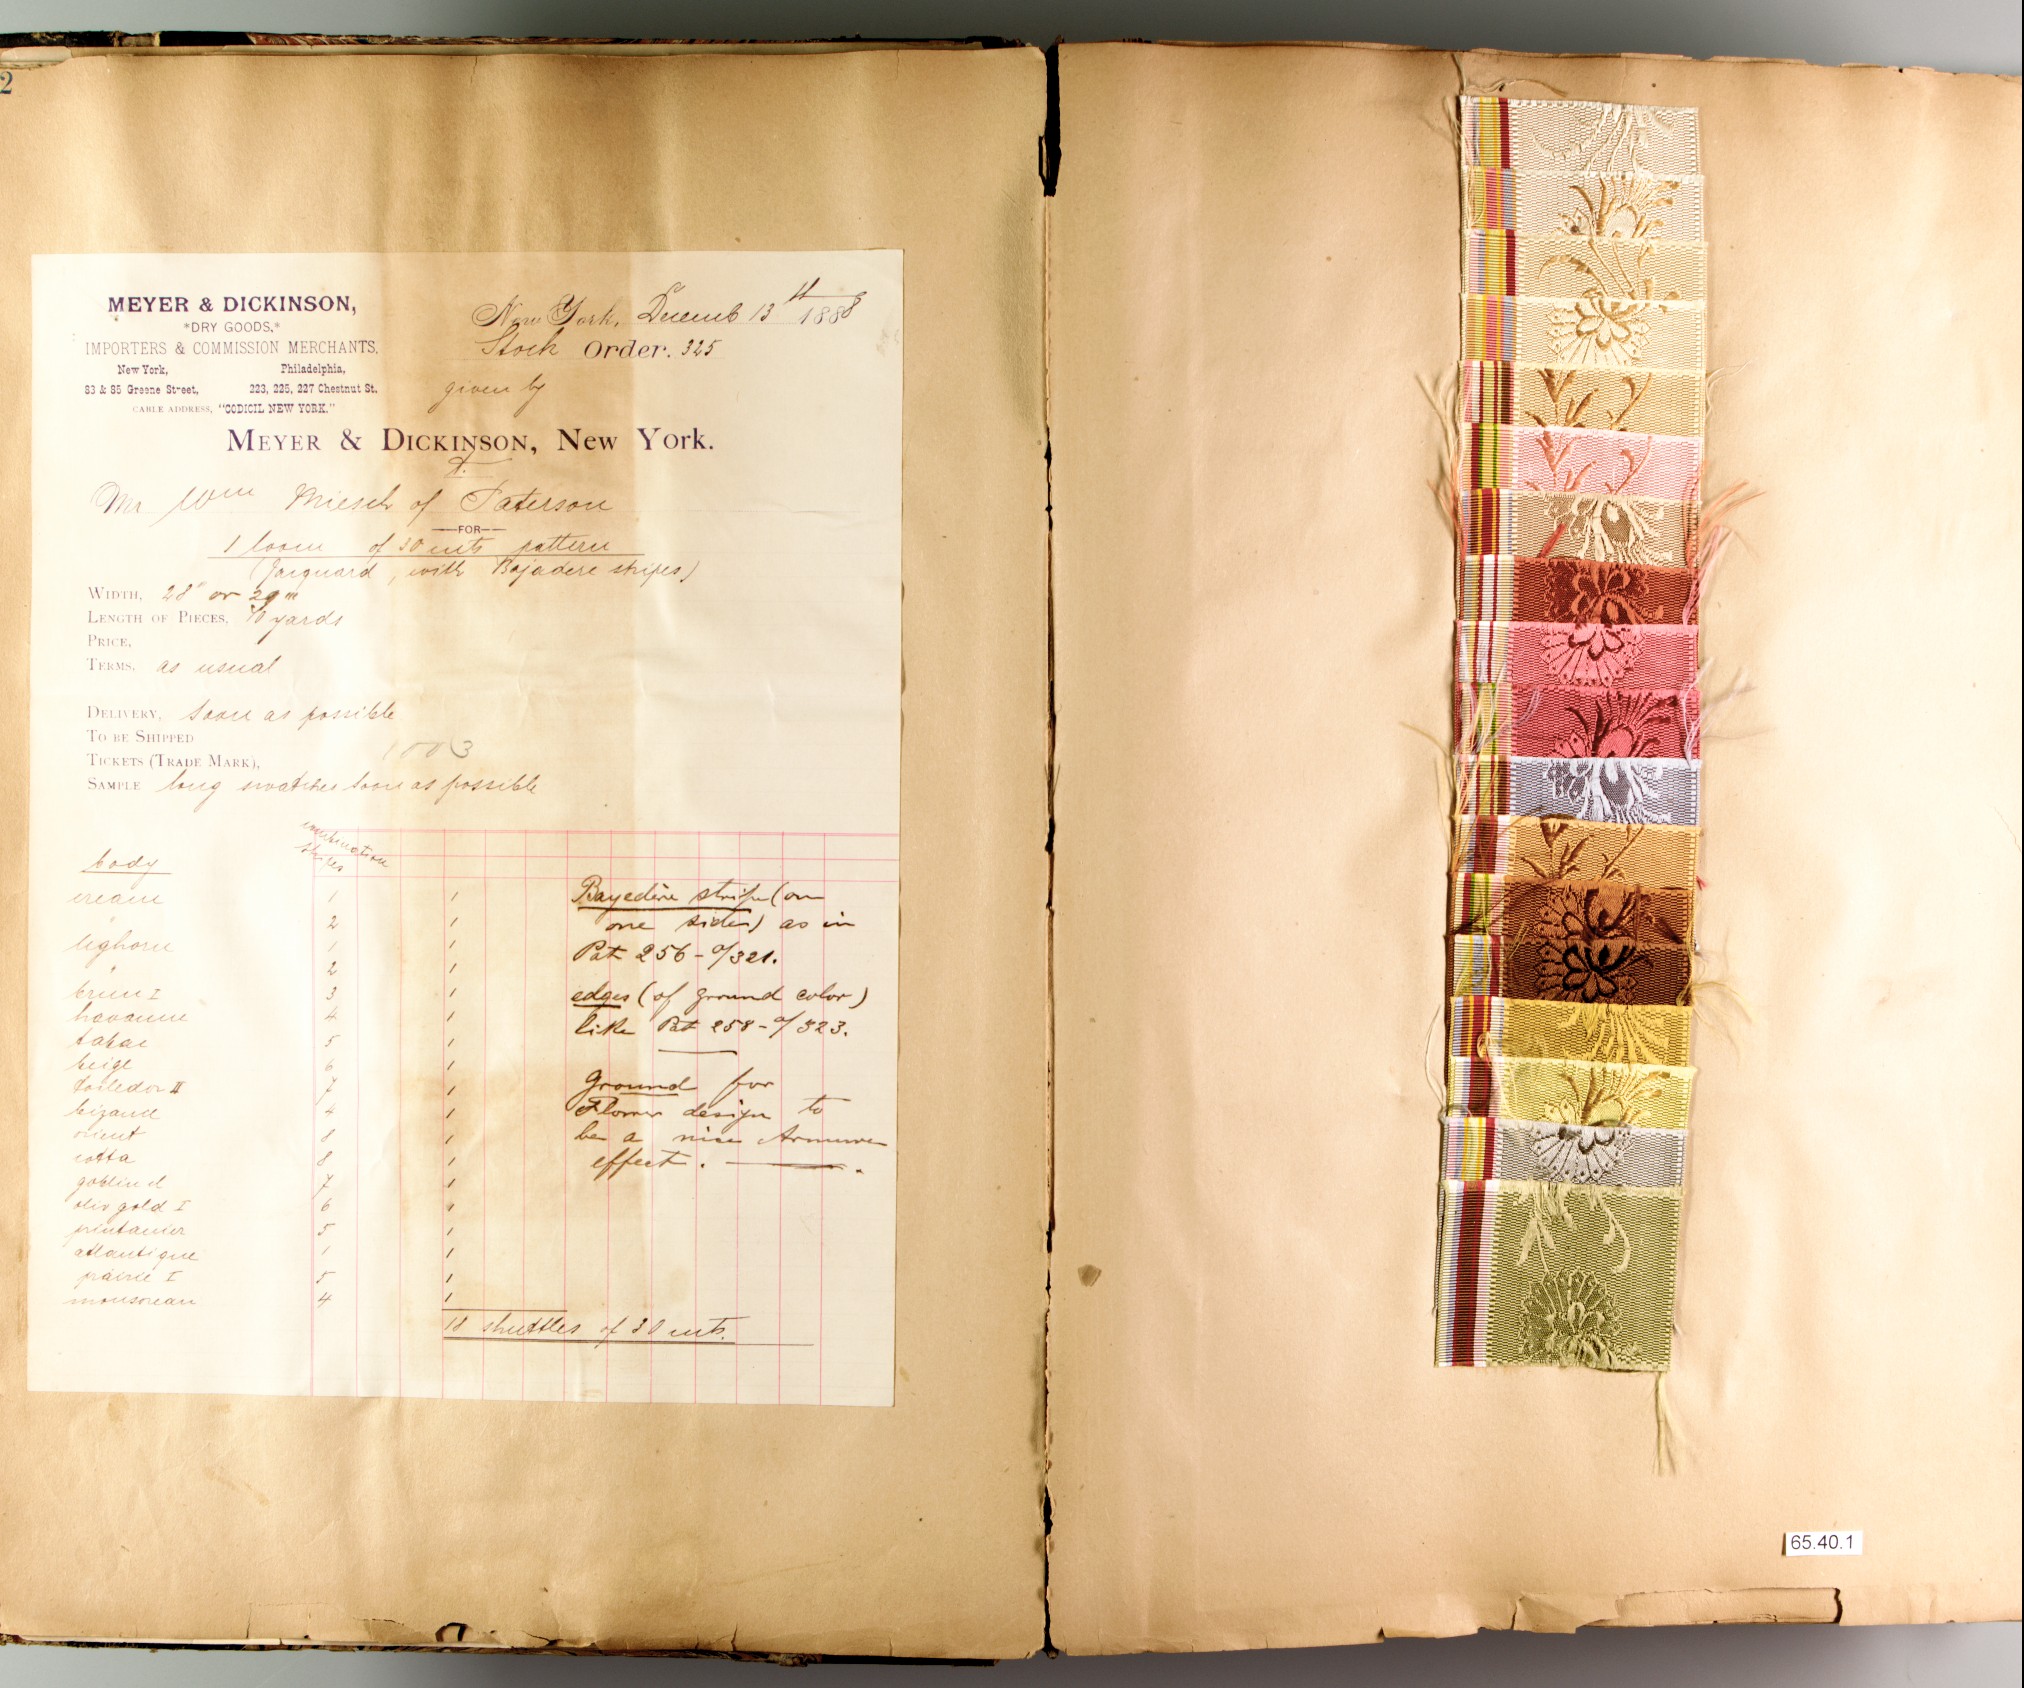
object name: sample book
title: Page of ribbon samples from a bound textile sample book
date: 1888-1890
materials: silk